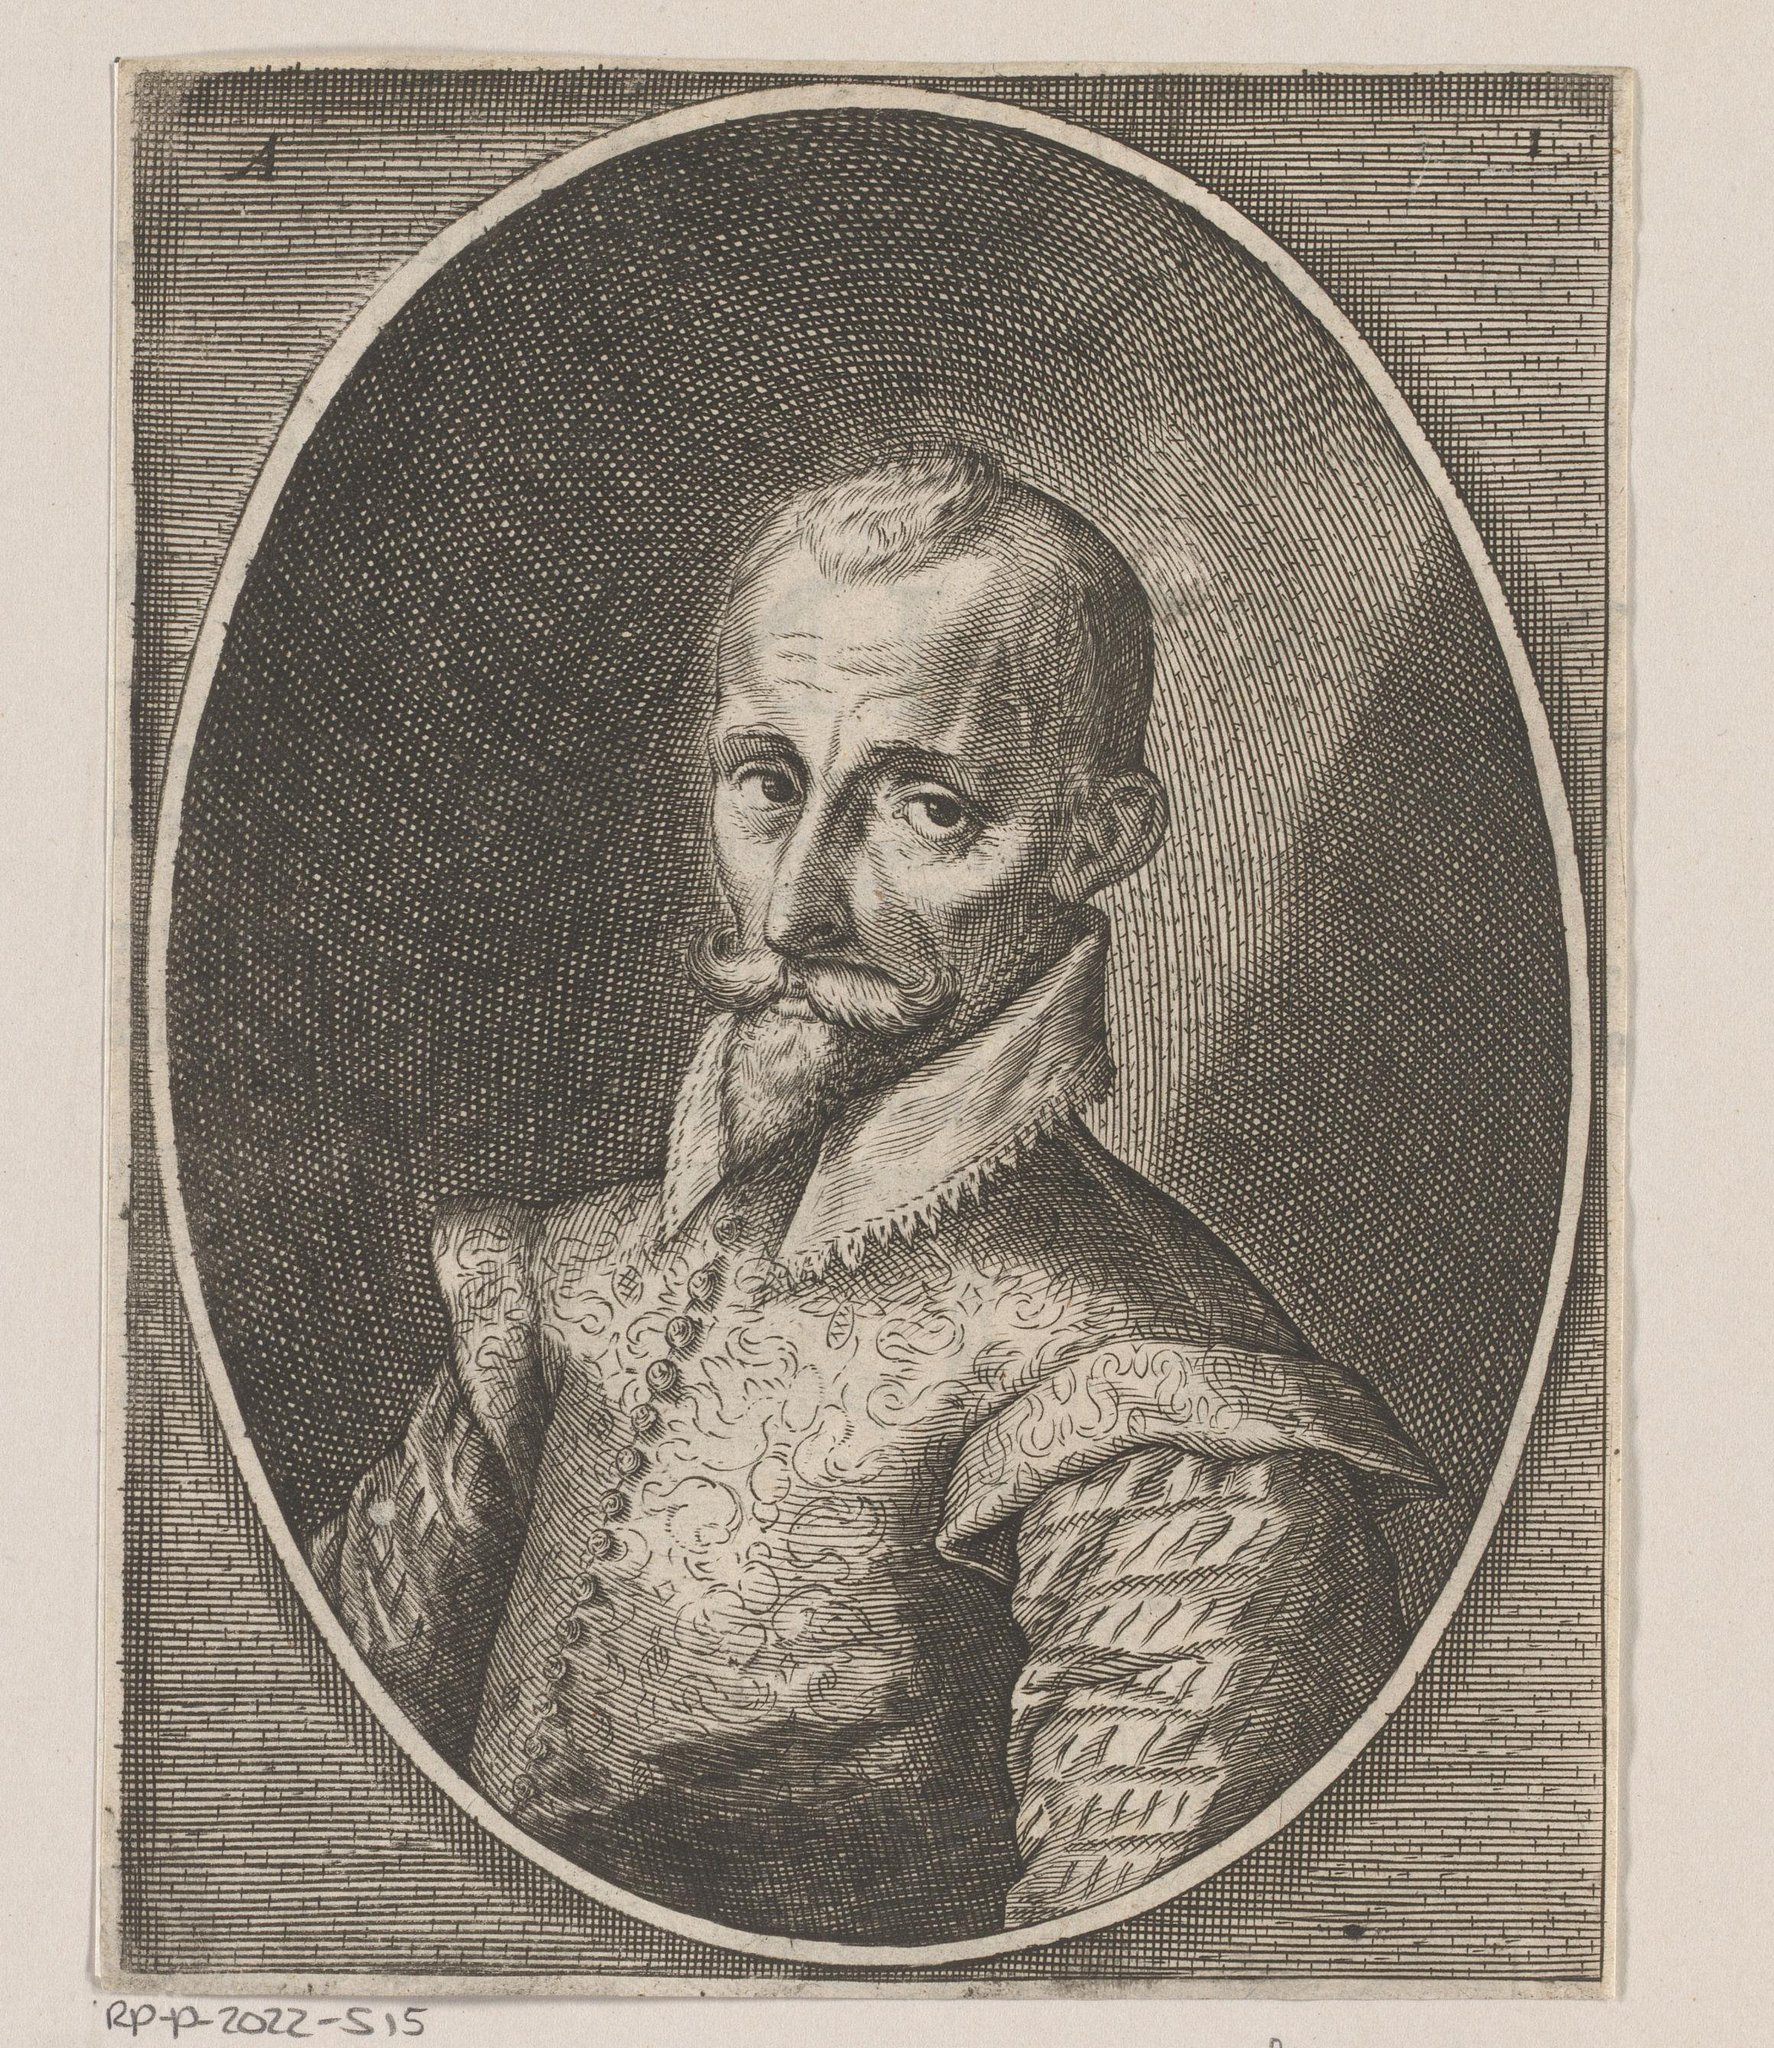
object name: book illustration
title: Portret Francisco Hurtado de Mendoza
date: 1665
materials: paper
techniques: engraving, letterpress printing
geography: amsterdam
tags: commander-in-chief, general, marshal, historical persons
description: Prent uit: Linschooten, Jan Huygen van. Journael van de derthien-jarighe Reyse, te water en te Lande (...). Amsterdam: Gillis Joosten Saeghman, 1665.